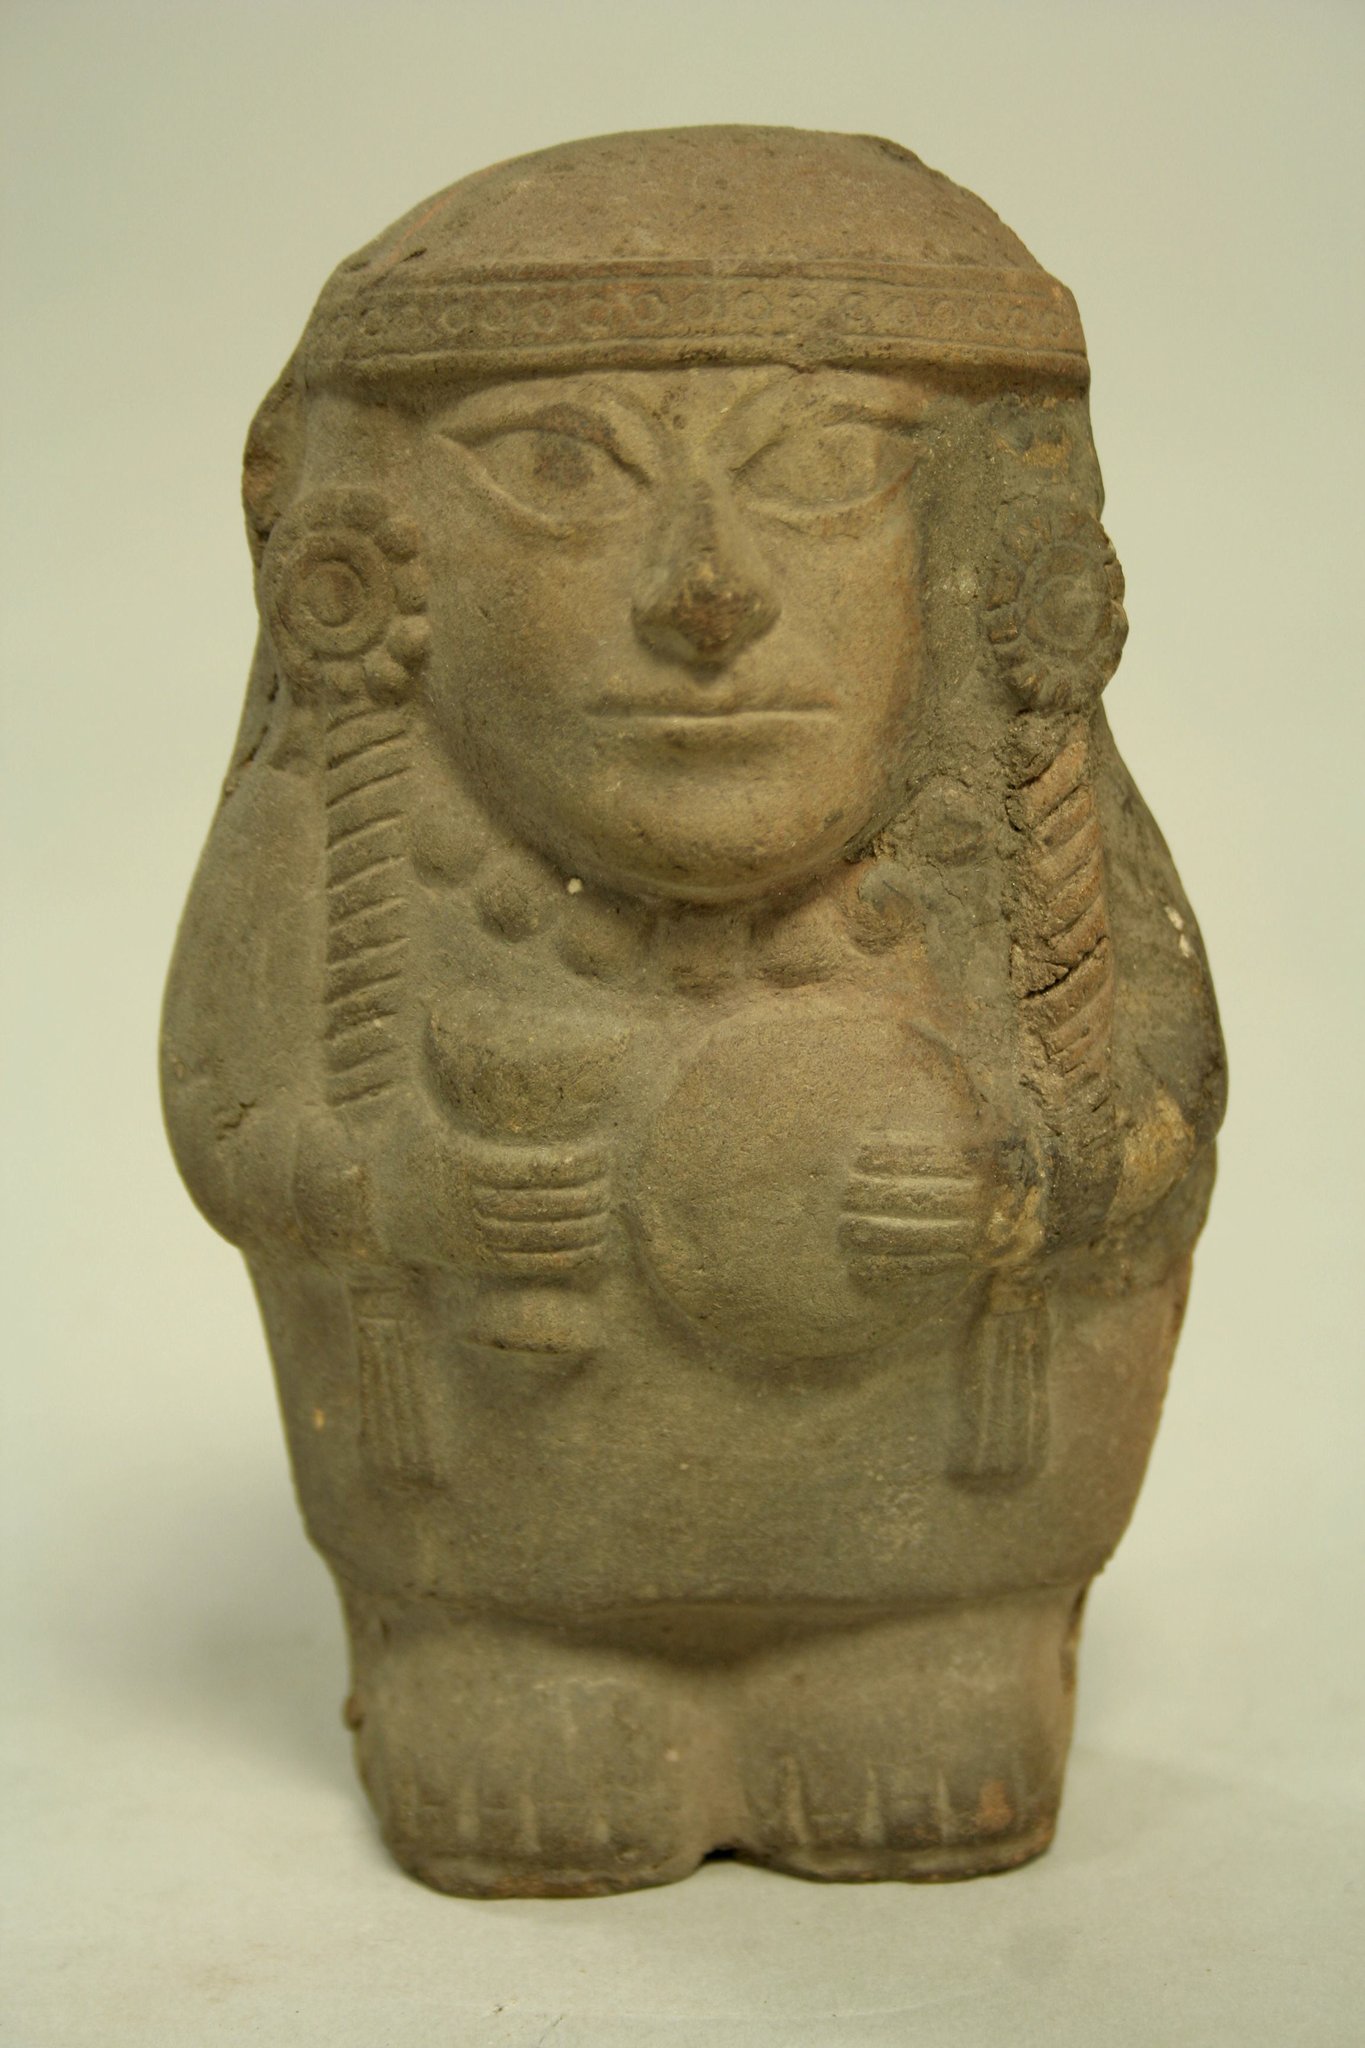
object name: figure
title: Standing Ceramic Figure Holding Disk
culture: moche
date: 301-500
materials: ceramic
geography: peru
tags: women